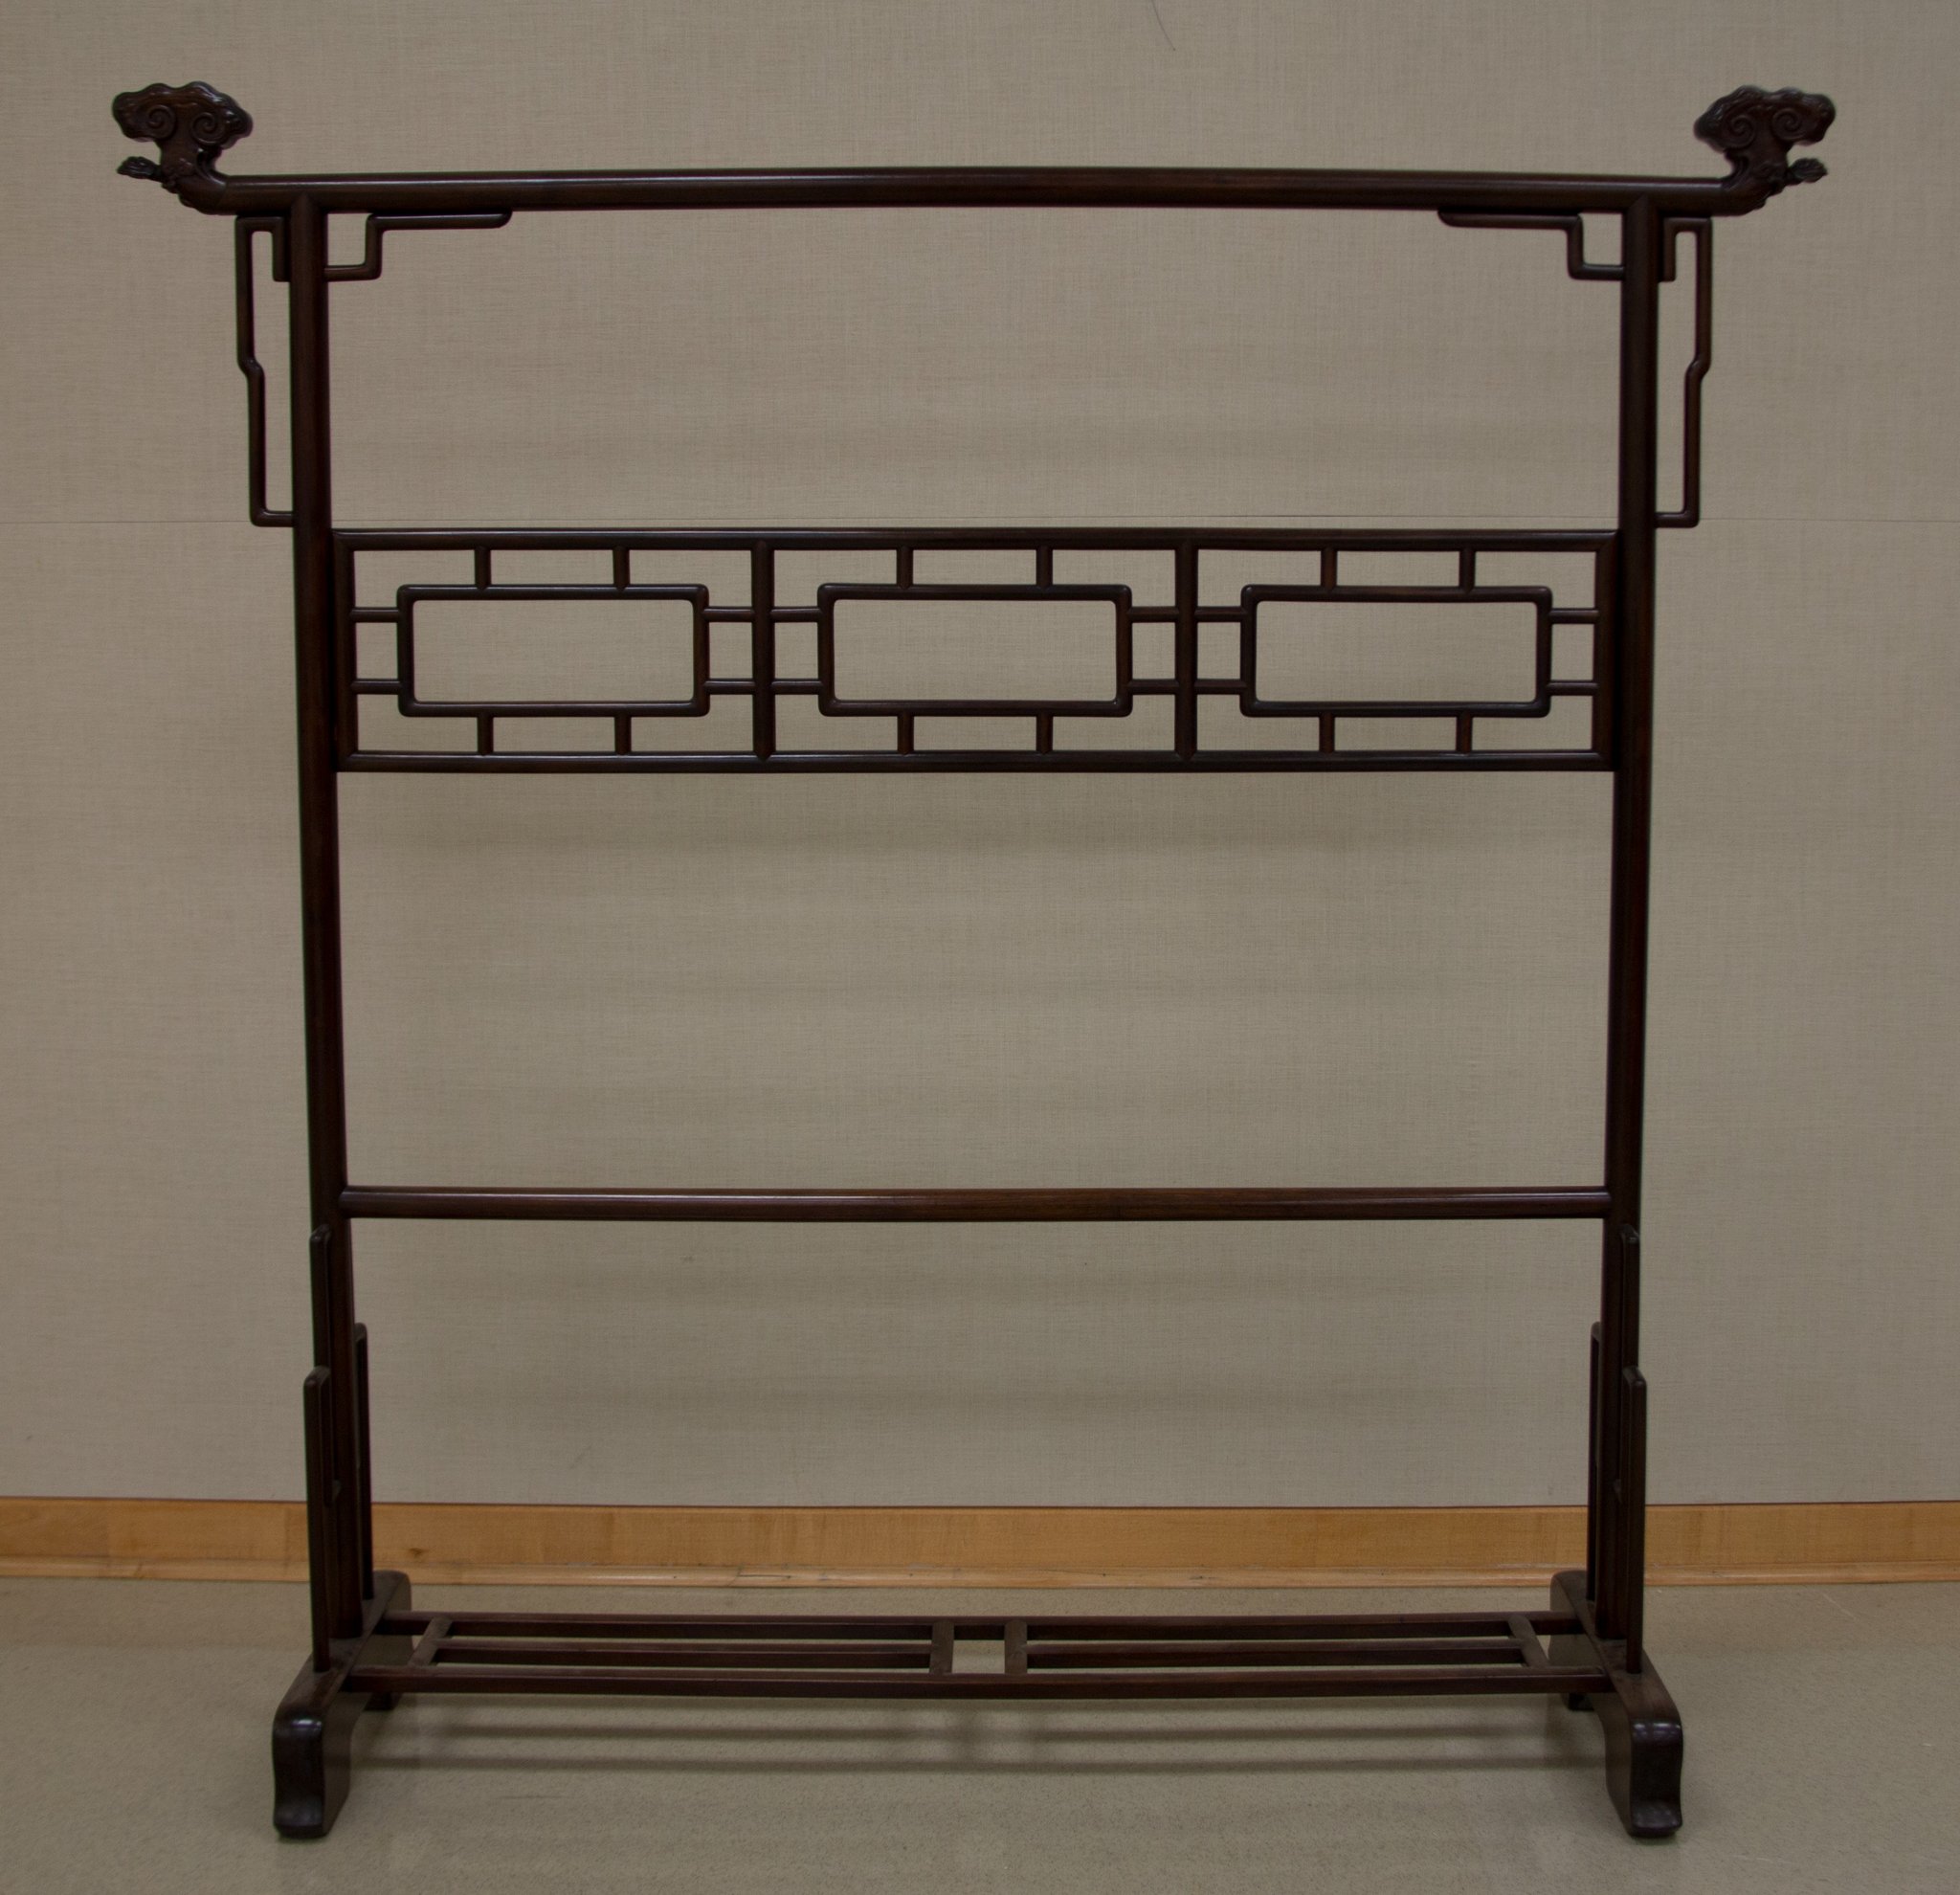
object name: robe rack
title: Robe Rack with Fungus-Shaped (Lingzhi) Terminals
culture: chinese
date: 1701-1800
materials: wood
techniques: carving